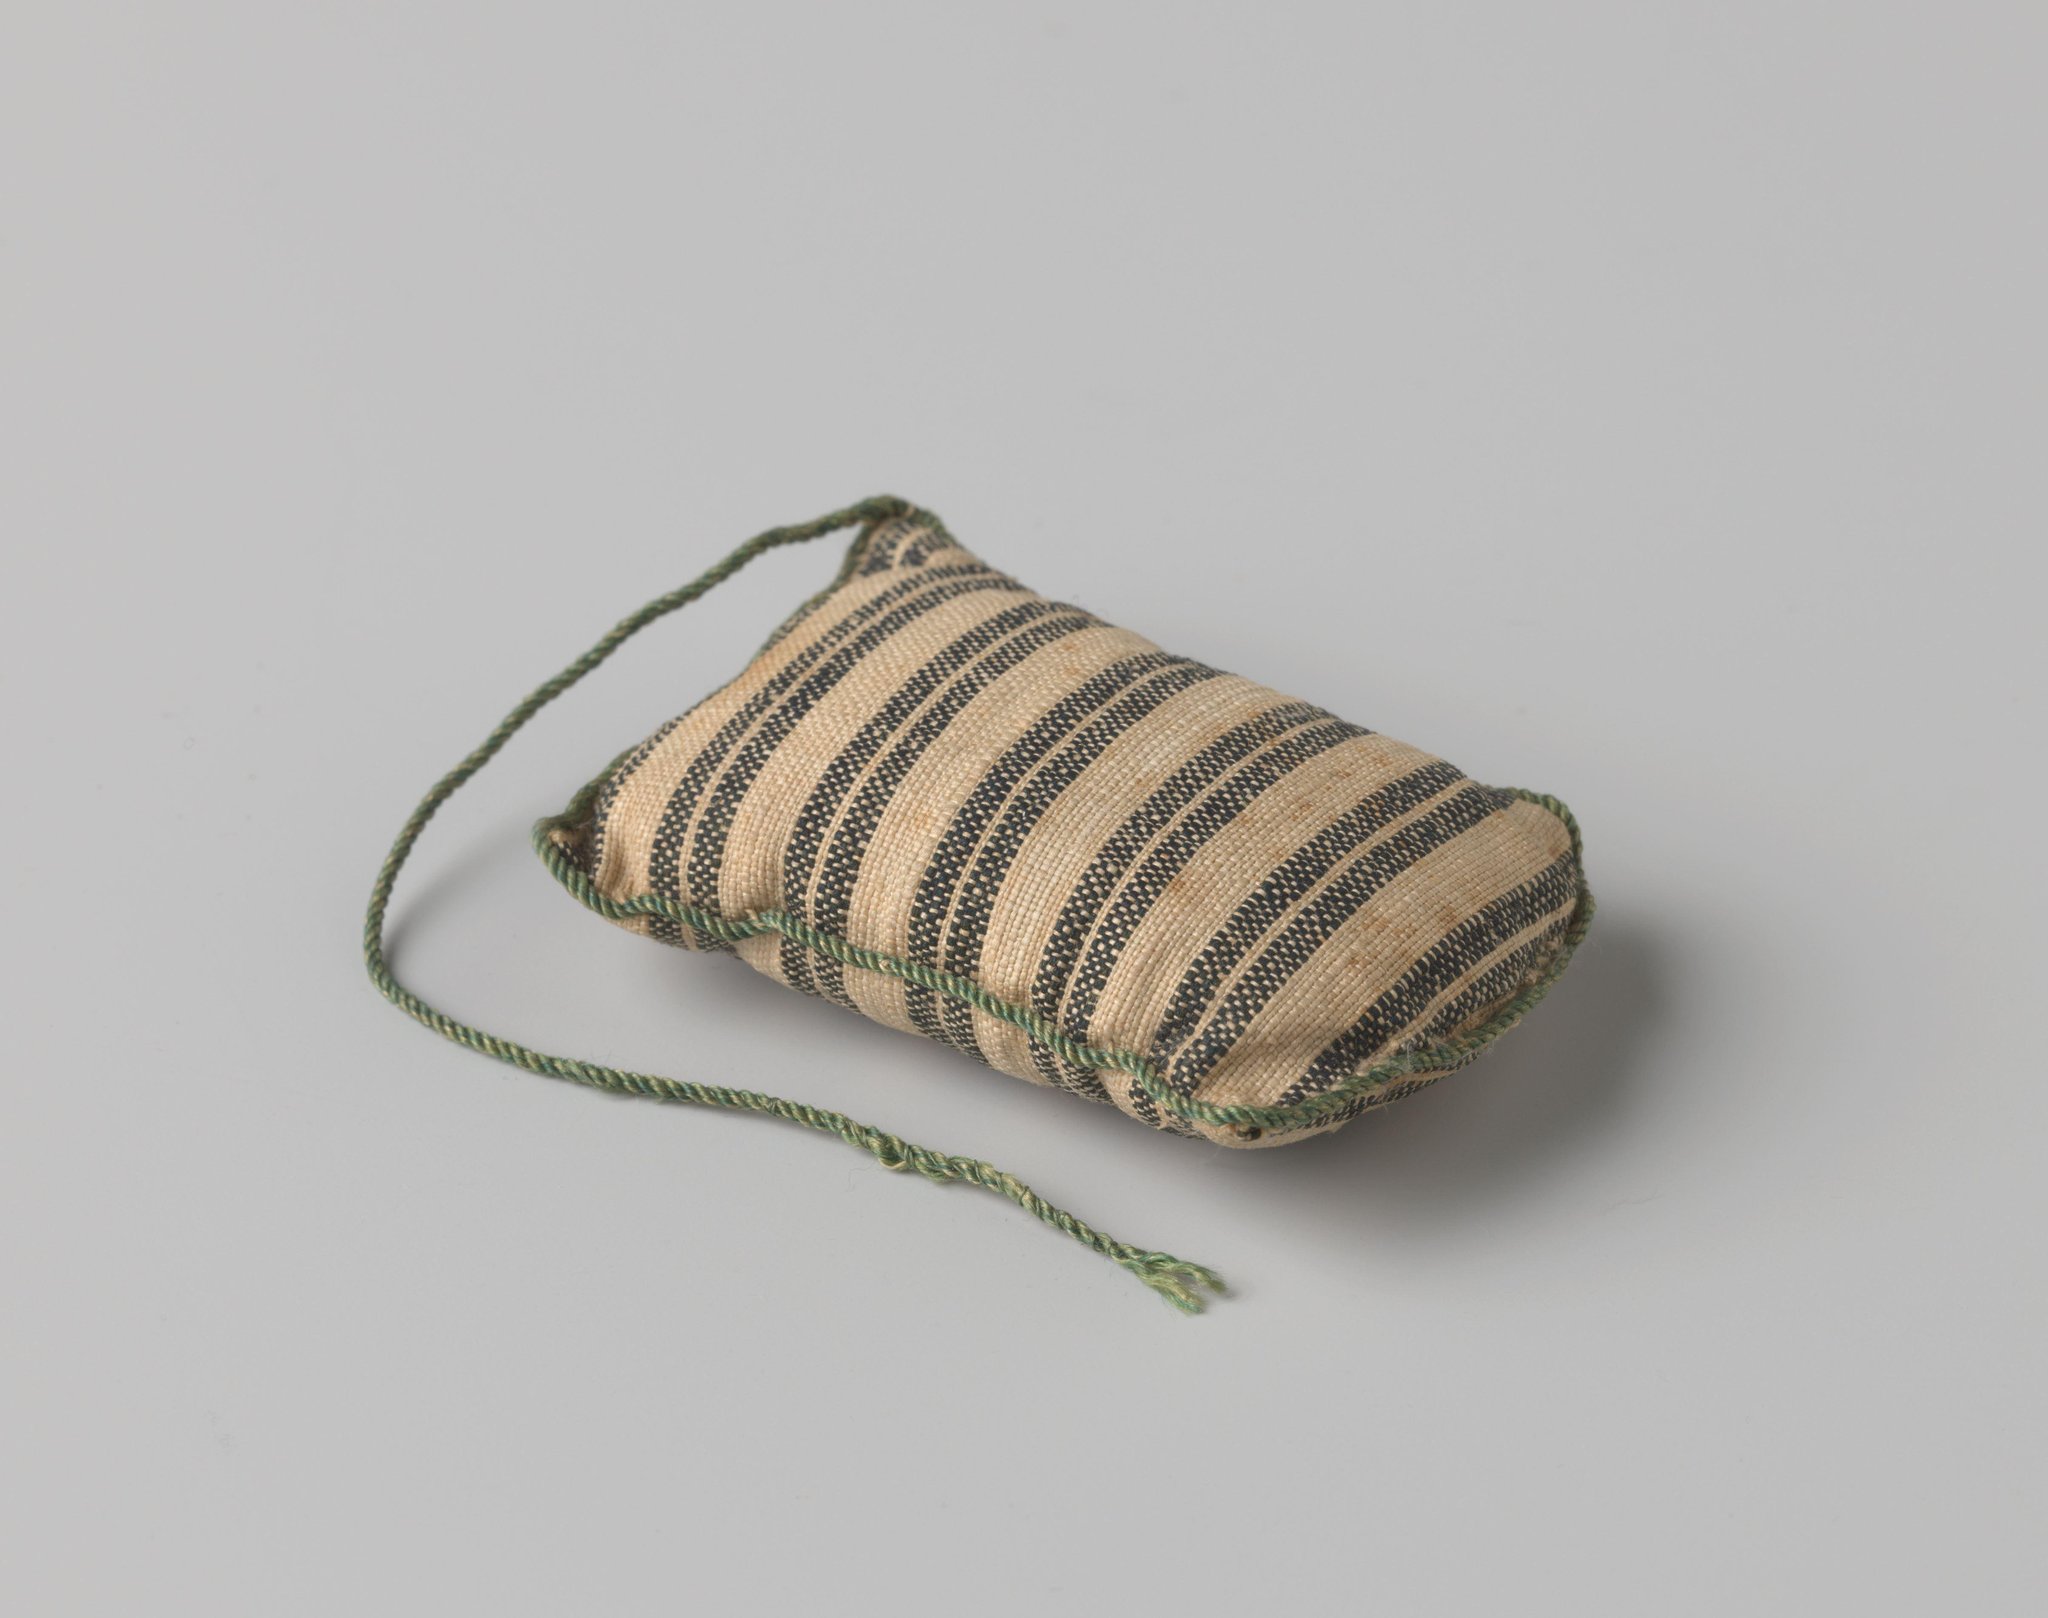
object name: miniature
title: Kussen, blauw-wit gestreept, omzoomd met een groen koord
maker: Anonymous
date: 1750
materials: cotton, down, linen, silk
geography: amsterdam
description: Een kussen van blauw wit gestreepte stof (wit linnen blauw katoen) gevuld met dons, omboord met een groen zijden koord, uitlopend in een los stuk. Een korte zijde recht, de andere korte zijde bolvormig.